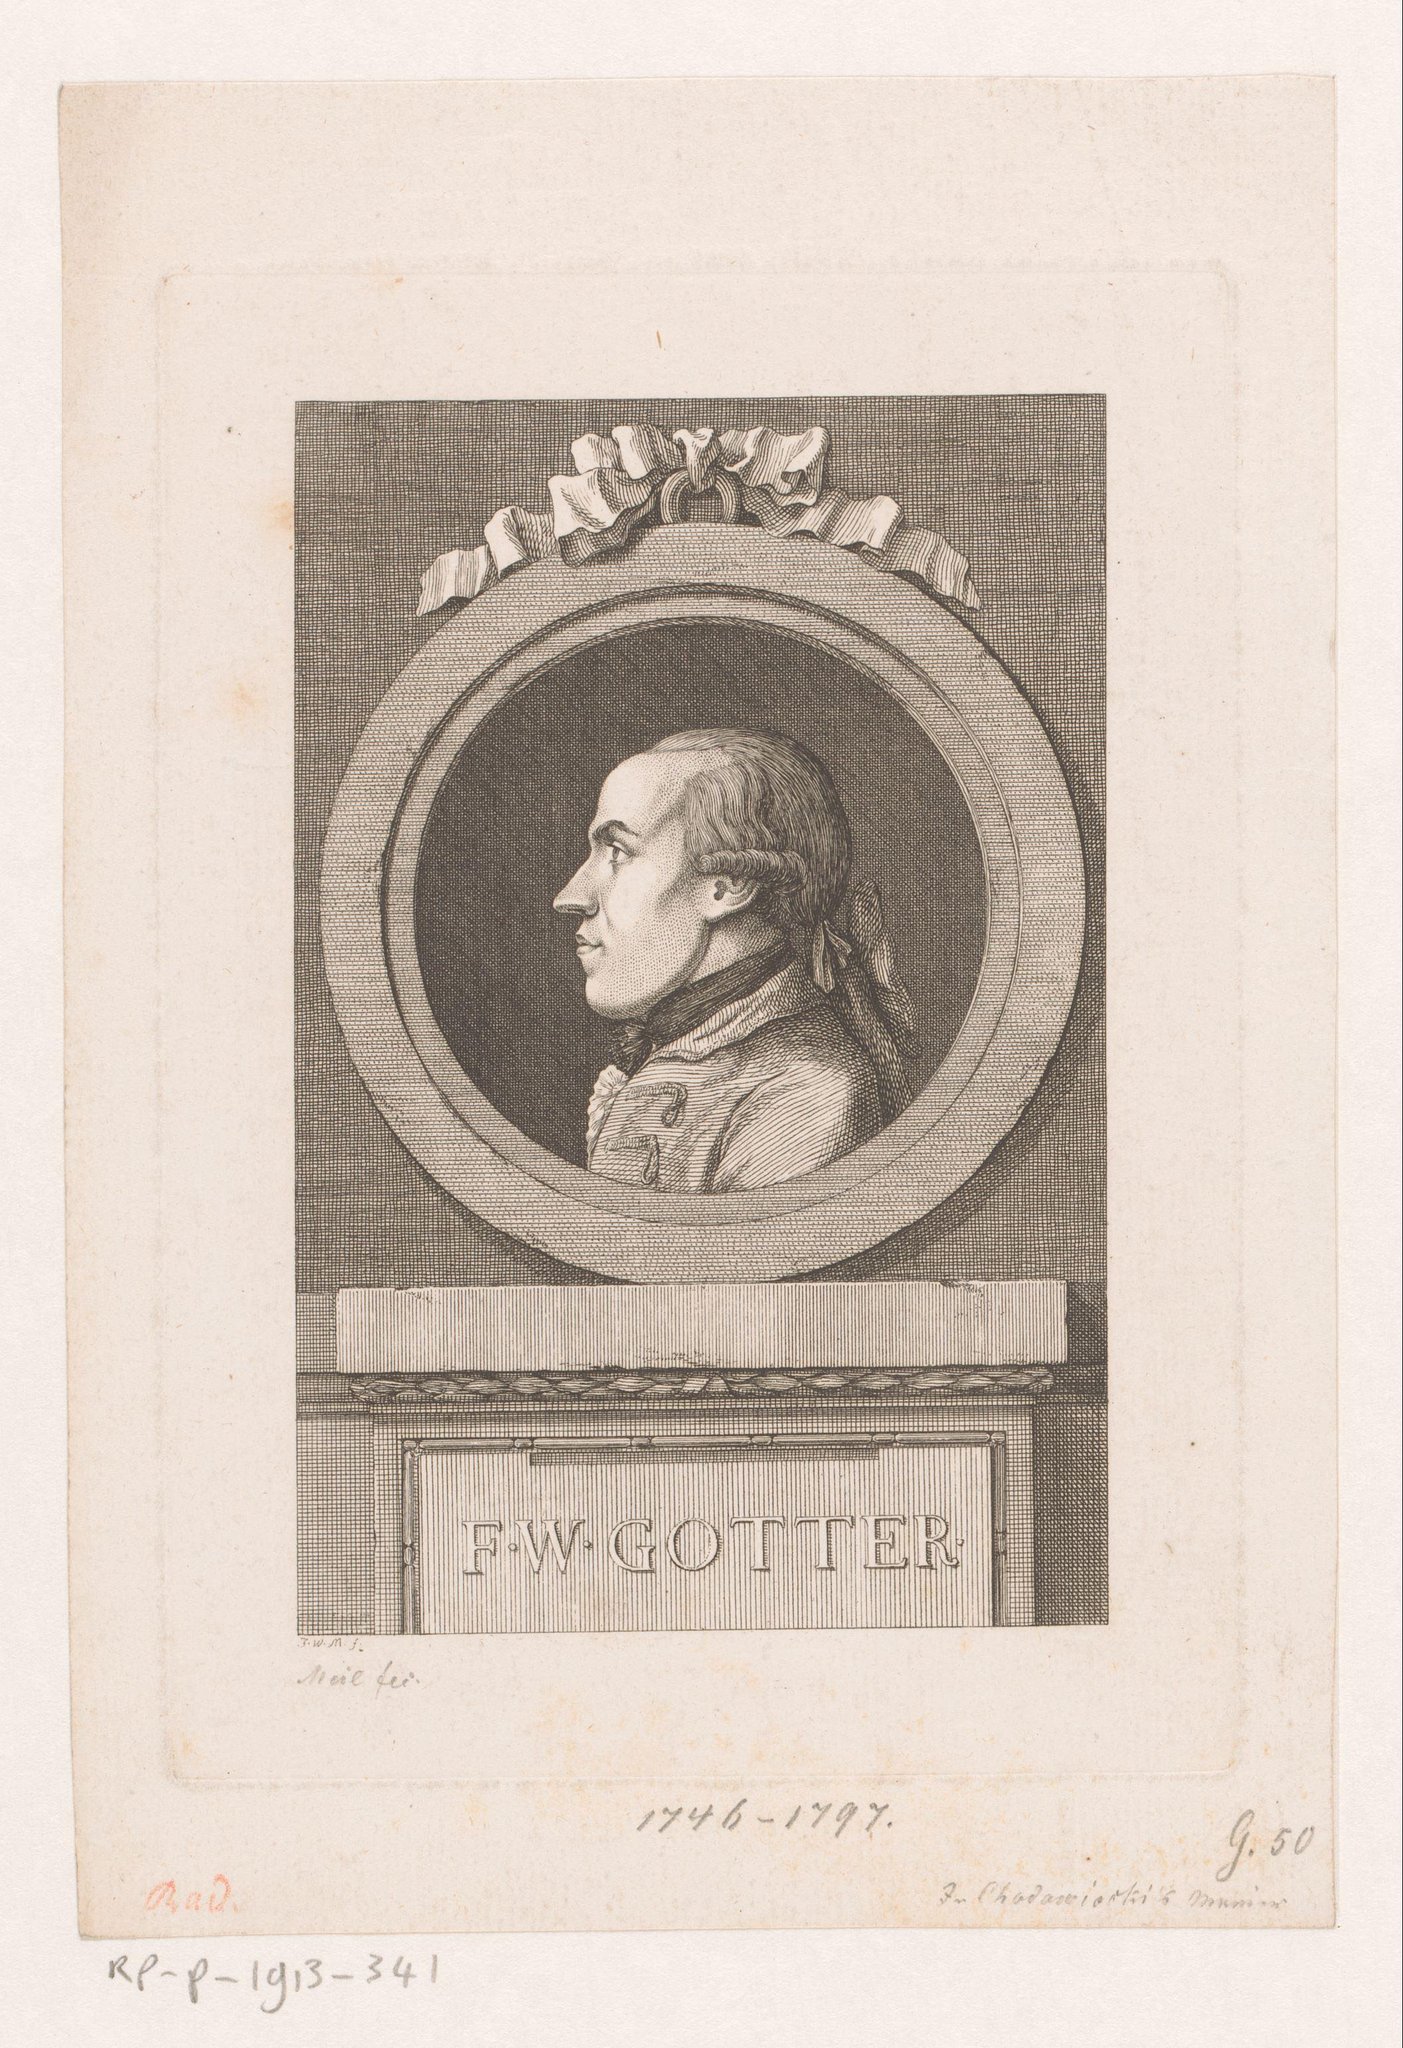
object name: print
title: Portret van Friedrich Wilhelm Gotter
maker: f.w.m. mueller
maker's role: print maker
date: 1766-1799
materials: paper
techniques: etching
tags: historical persons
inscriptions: collector's mark: Lugt 2228